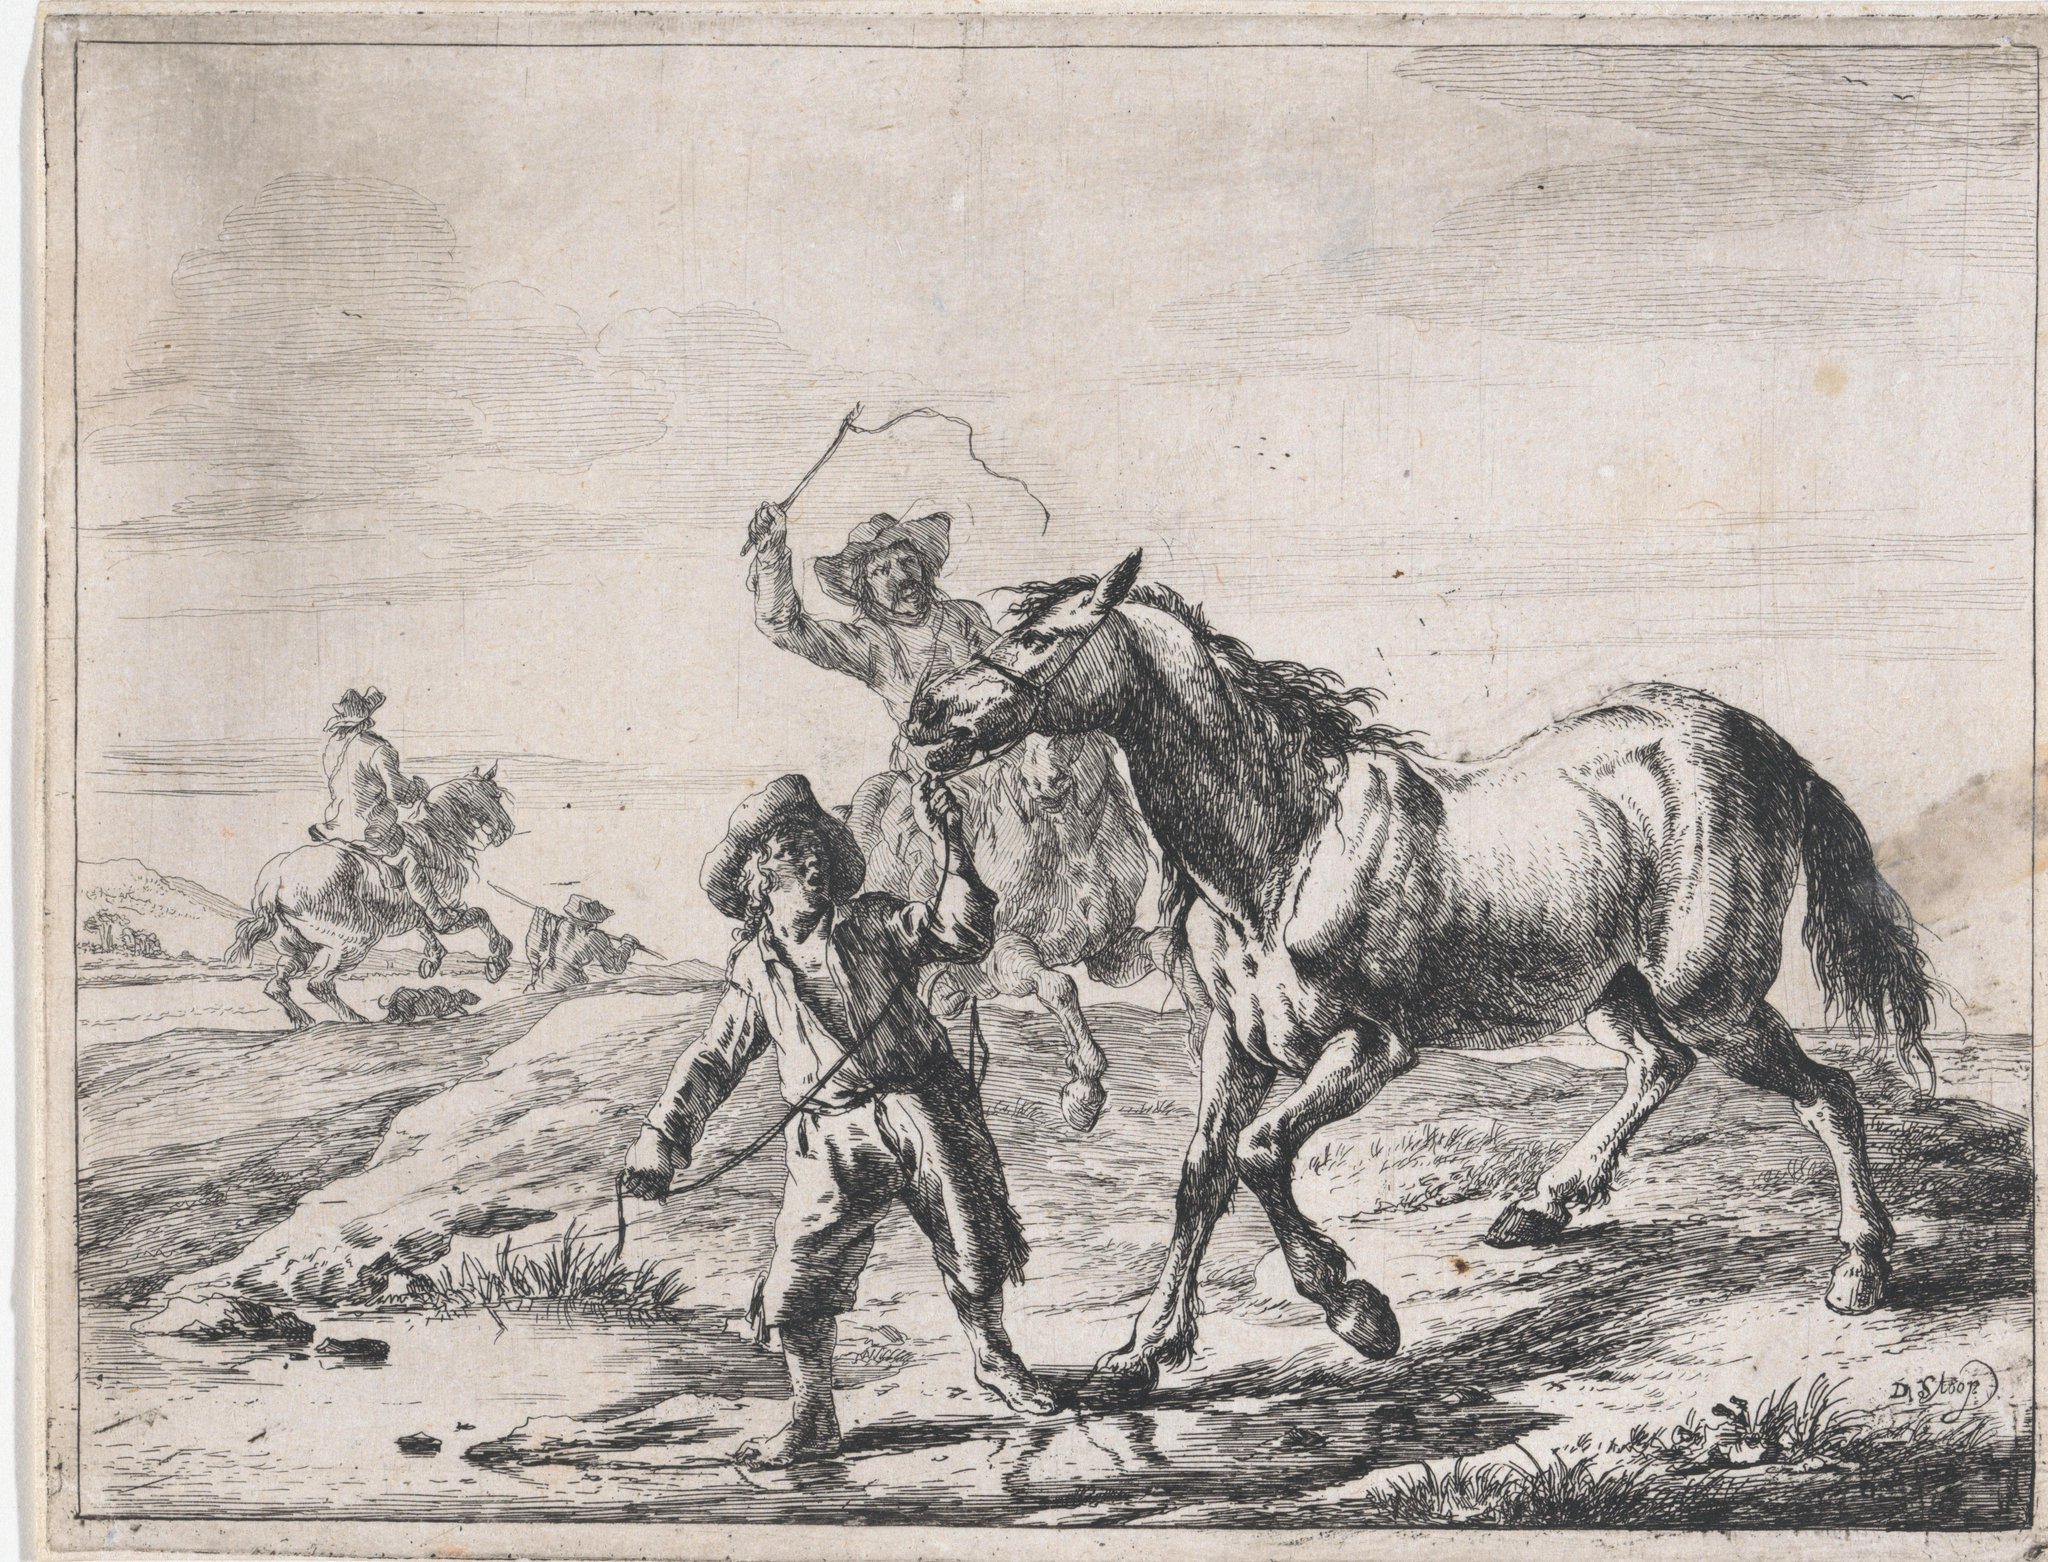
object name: print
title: Paarden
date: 1651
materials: paper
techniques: etching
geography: utrecht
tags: horse (+ animals eating and drinking)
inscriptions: collector's mark: Lugt 2228, collector's mark: Lugt 240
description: Een jongen leidt een paard naar het water om het te laten drinken. Op de achtergrond ruiters.